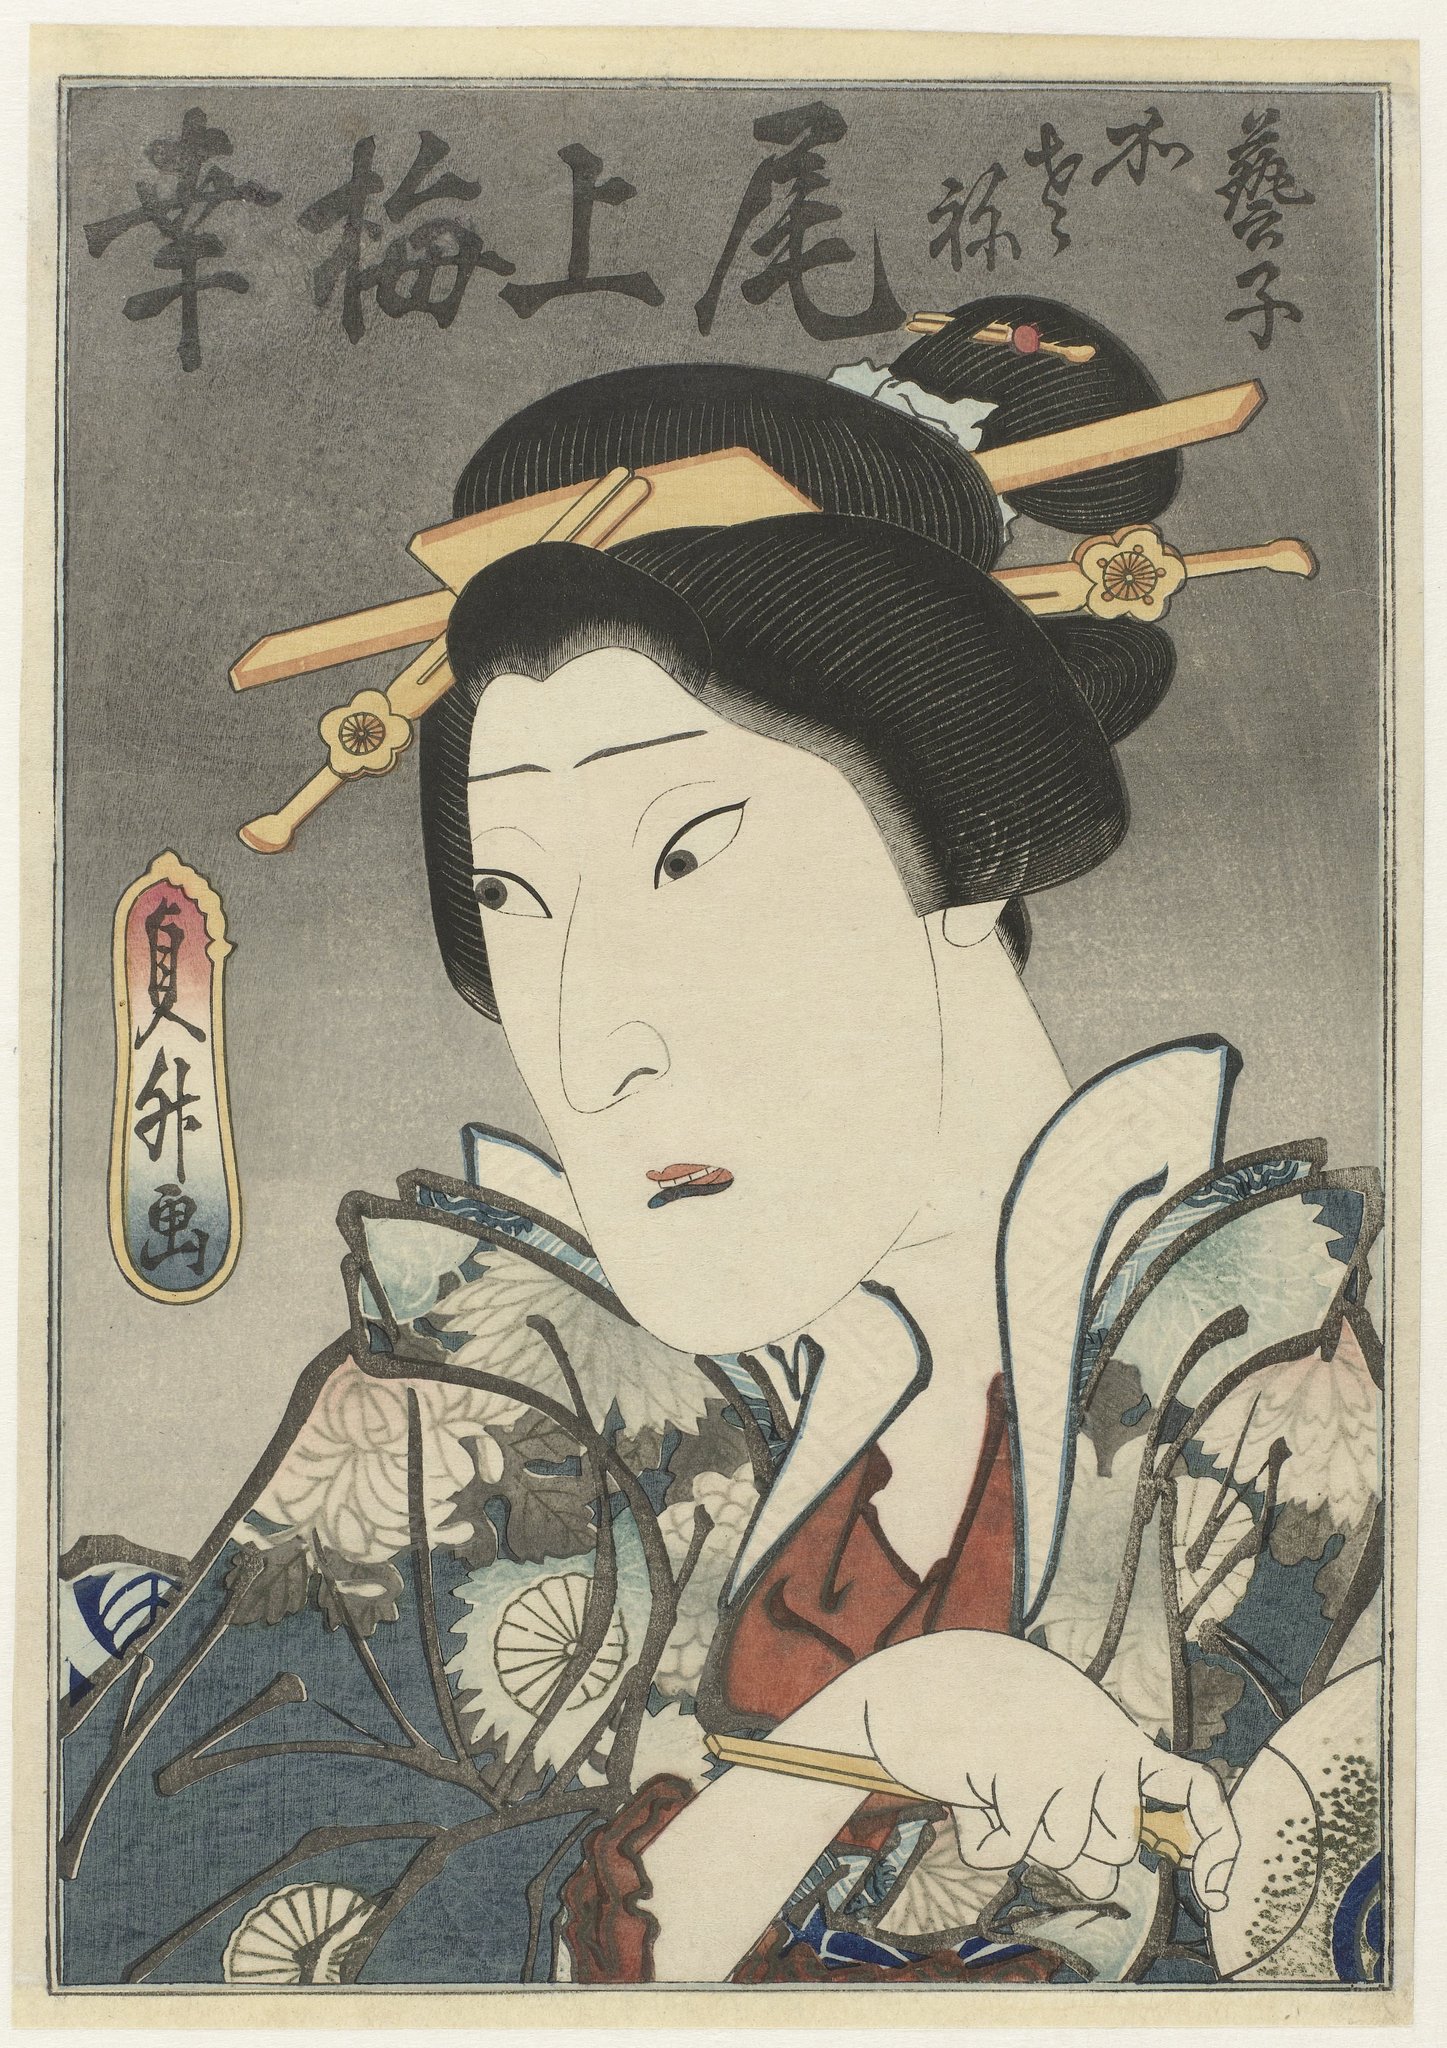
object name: print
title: Onoe Baikô III in vrouwenrol met waaier in de hand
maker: utagawa sadamasu (ii)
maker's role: print maker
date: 1805-1841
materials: paper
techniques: woodcut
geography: osaka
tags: japan, female impersonation by actor, fan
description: Toneelspeler Onoe Baikô III (Kikugorô III) in de rol van geisha Kasane, in het stuk ‘Kasane ôgi hagi no datezome’, opgevoerd in het Kado Theater in de vijfde maand van 1841.